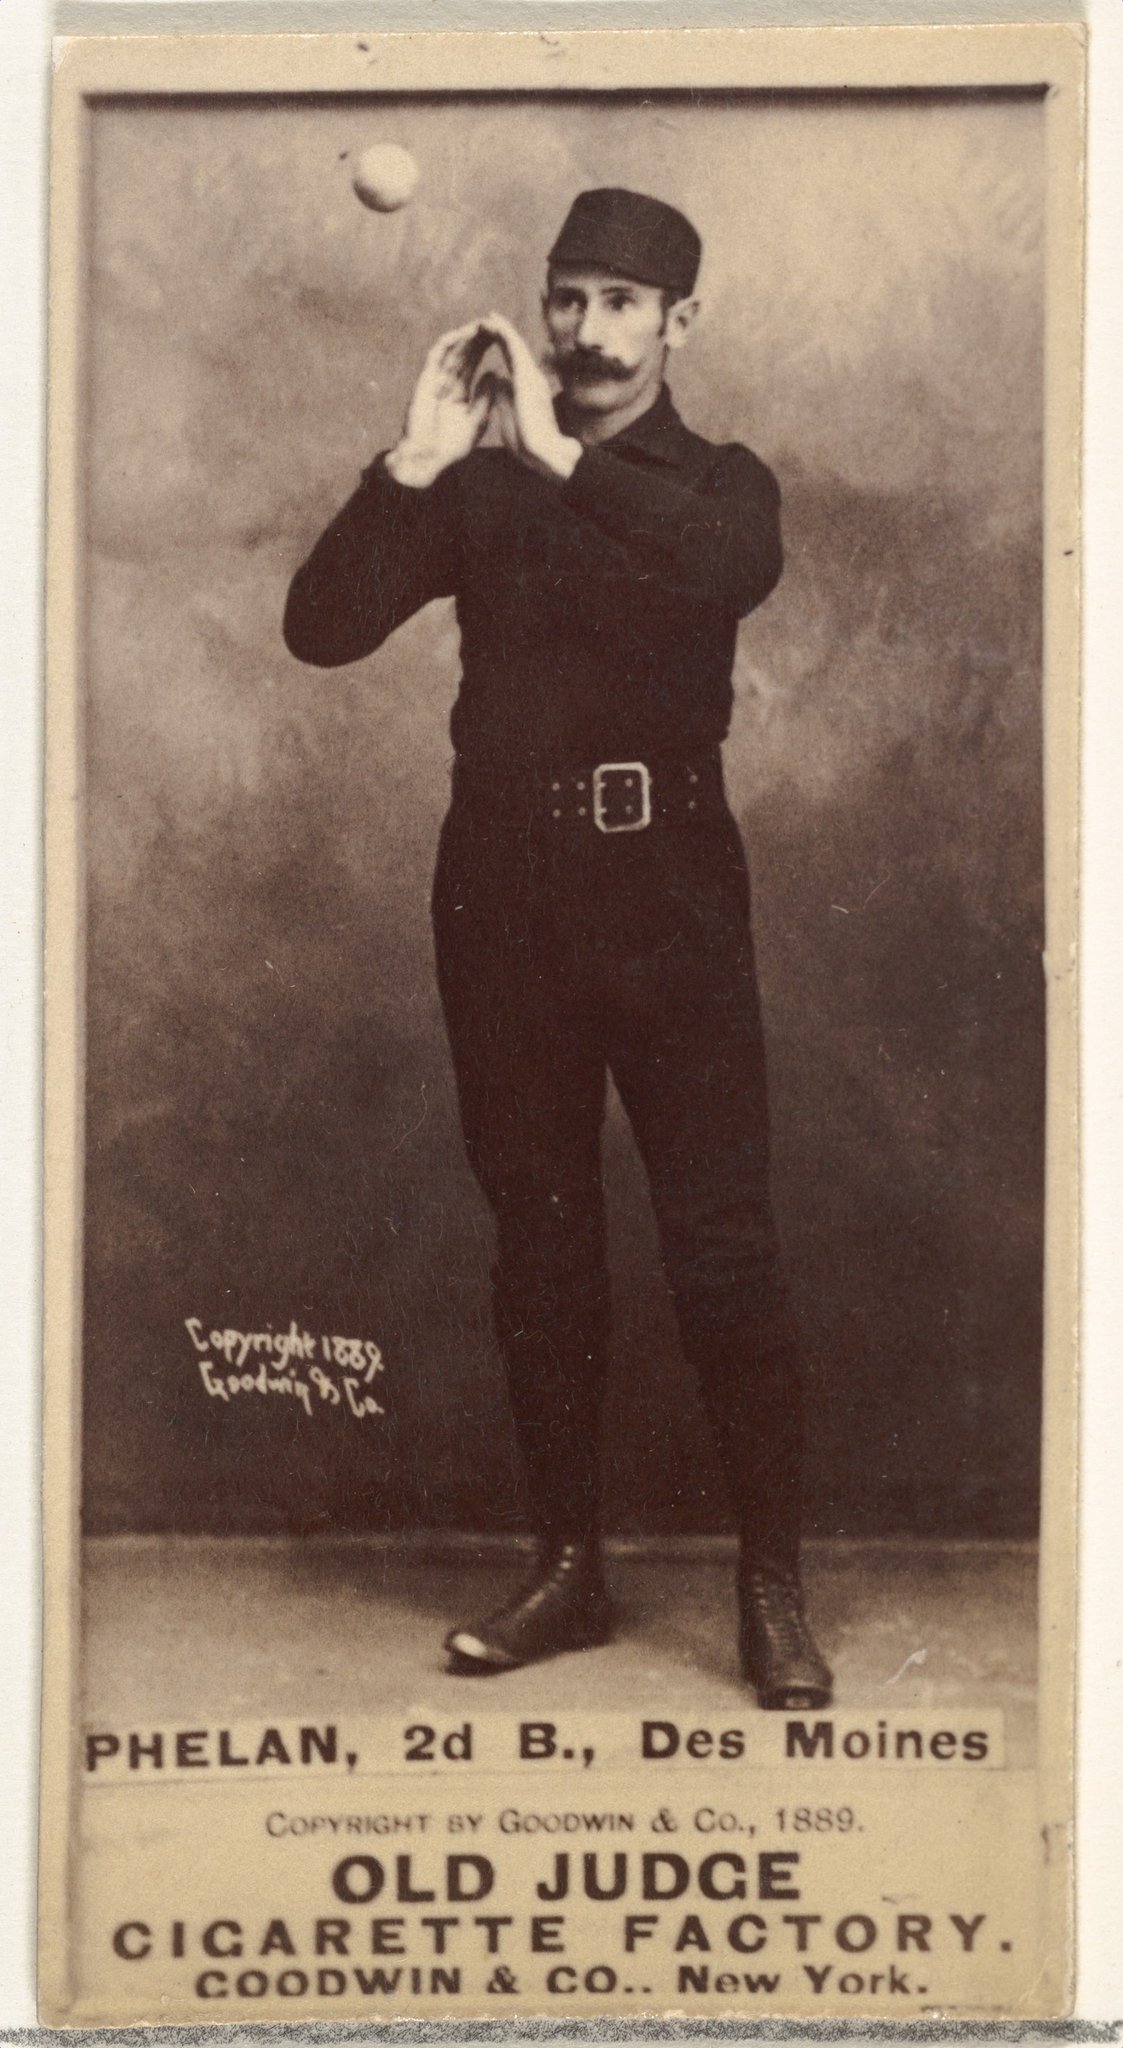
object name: baseball card, photograph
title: James Dickson "Dick" Phelan, 2nd Base, Des Moines Prohibitionists, from the Old Judge series (N172) for Old Judge Cigarettes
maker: goodwin & company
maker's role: publisher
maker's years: 1850-1950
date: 1889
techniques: albumen silver print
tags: men,portraits,baseball,athletes